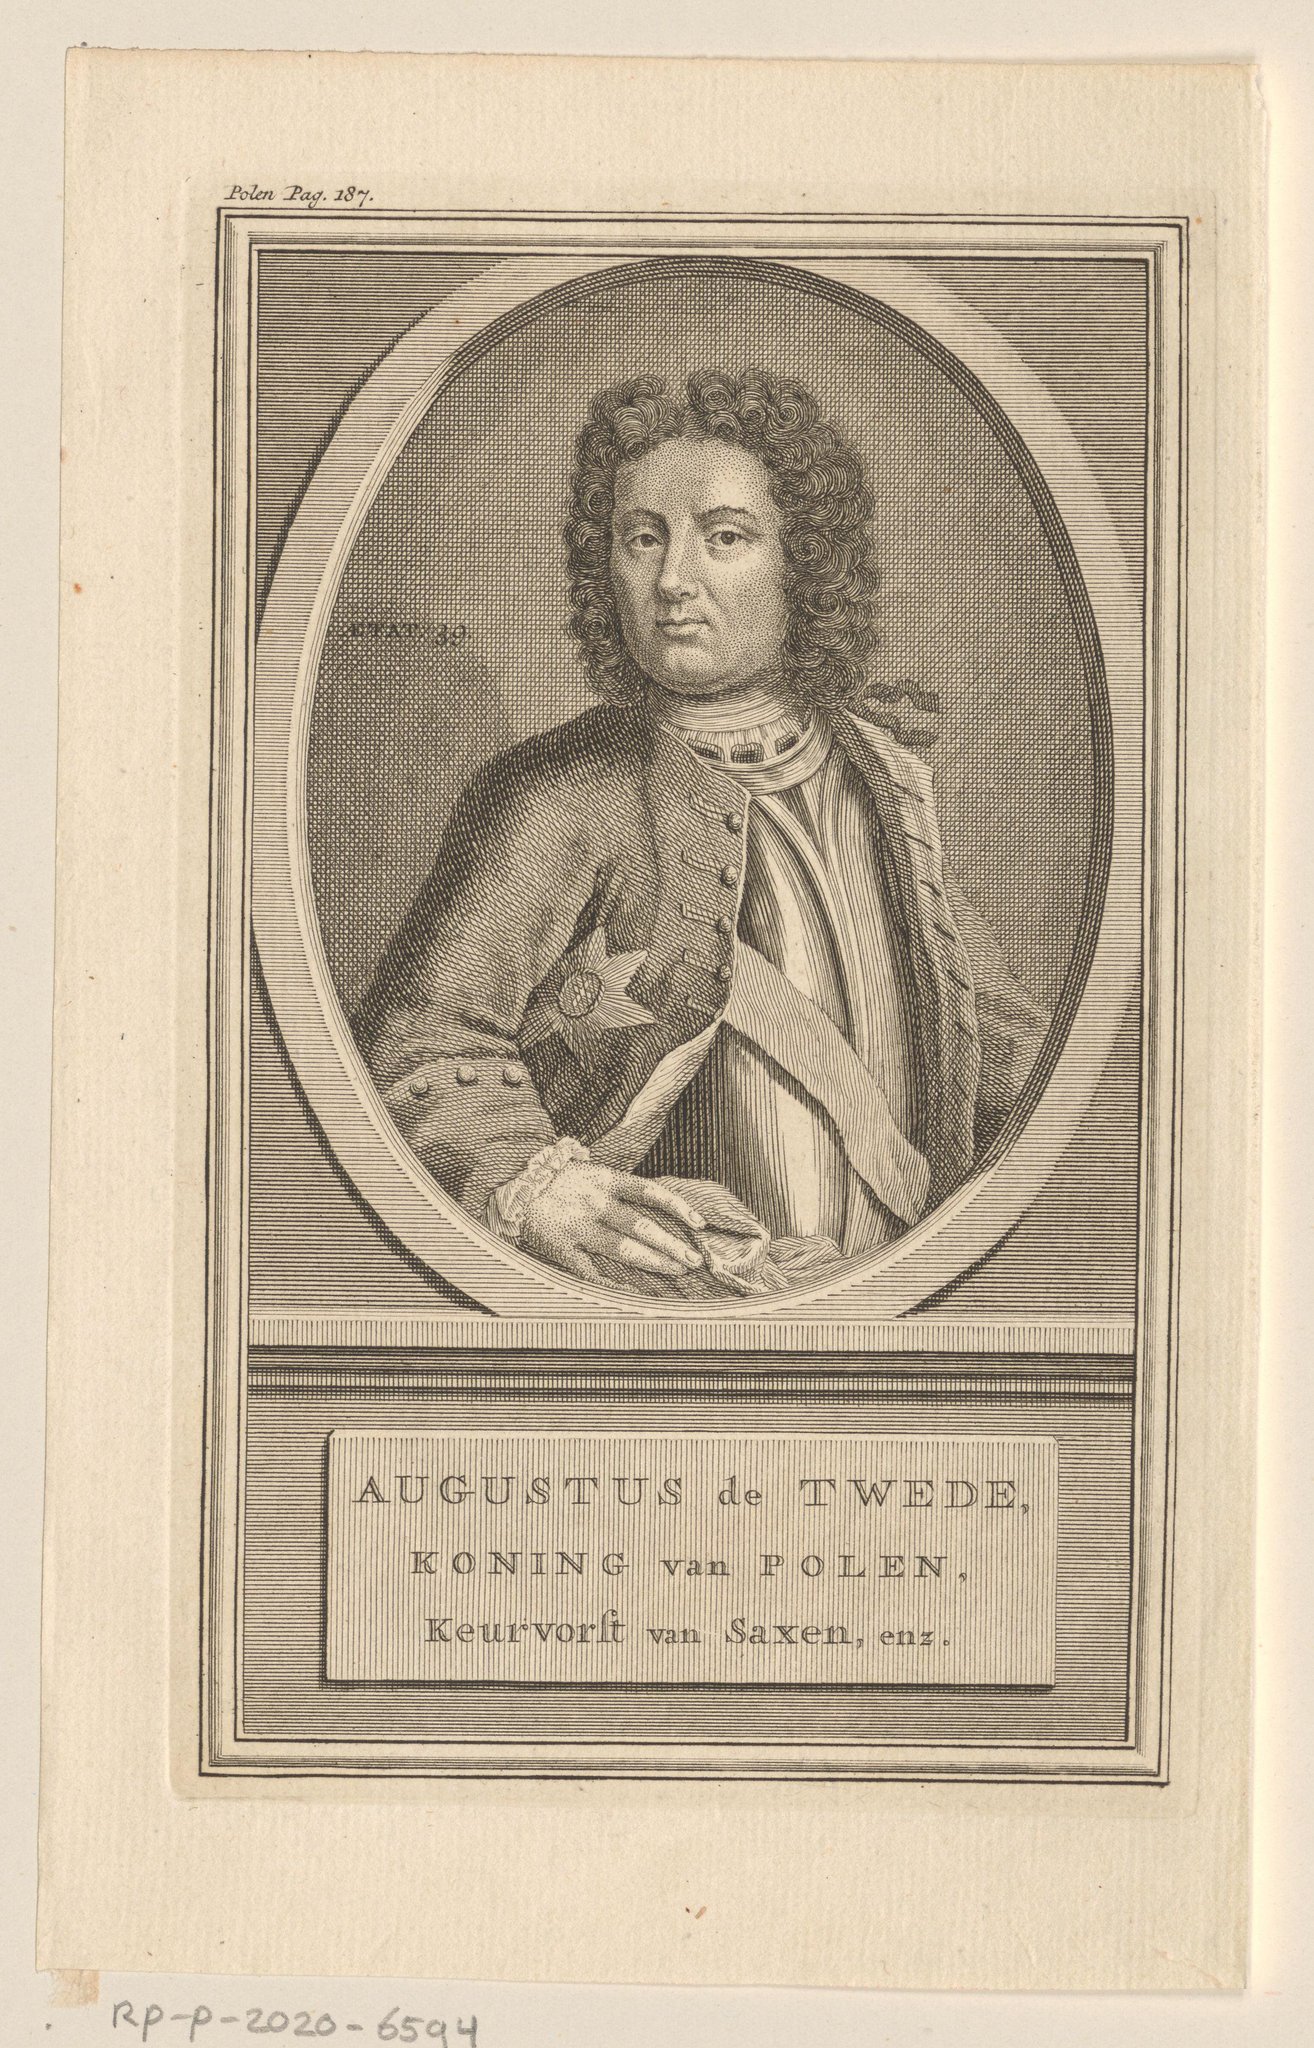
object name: print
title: Portret van August II van Polen op 39-jarige leeftijd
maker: Anonymous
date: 1734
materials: paper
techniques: etching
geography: amsterdam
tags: august ii (king of poland), ornament ~ medallion, historical persons, king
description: Prent waarschijnlijk uit: Salmon, Thomas. Hedendaagsche historie of tegenwoordige staat van alle volkeren (...). Amsterdam: Isaak Tirion, 1734, dl. 6.